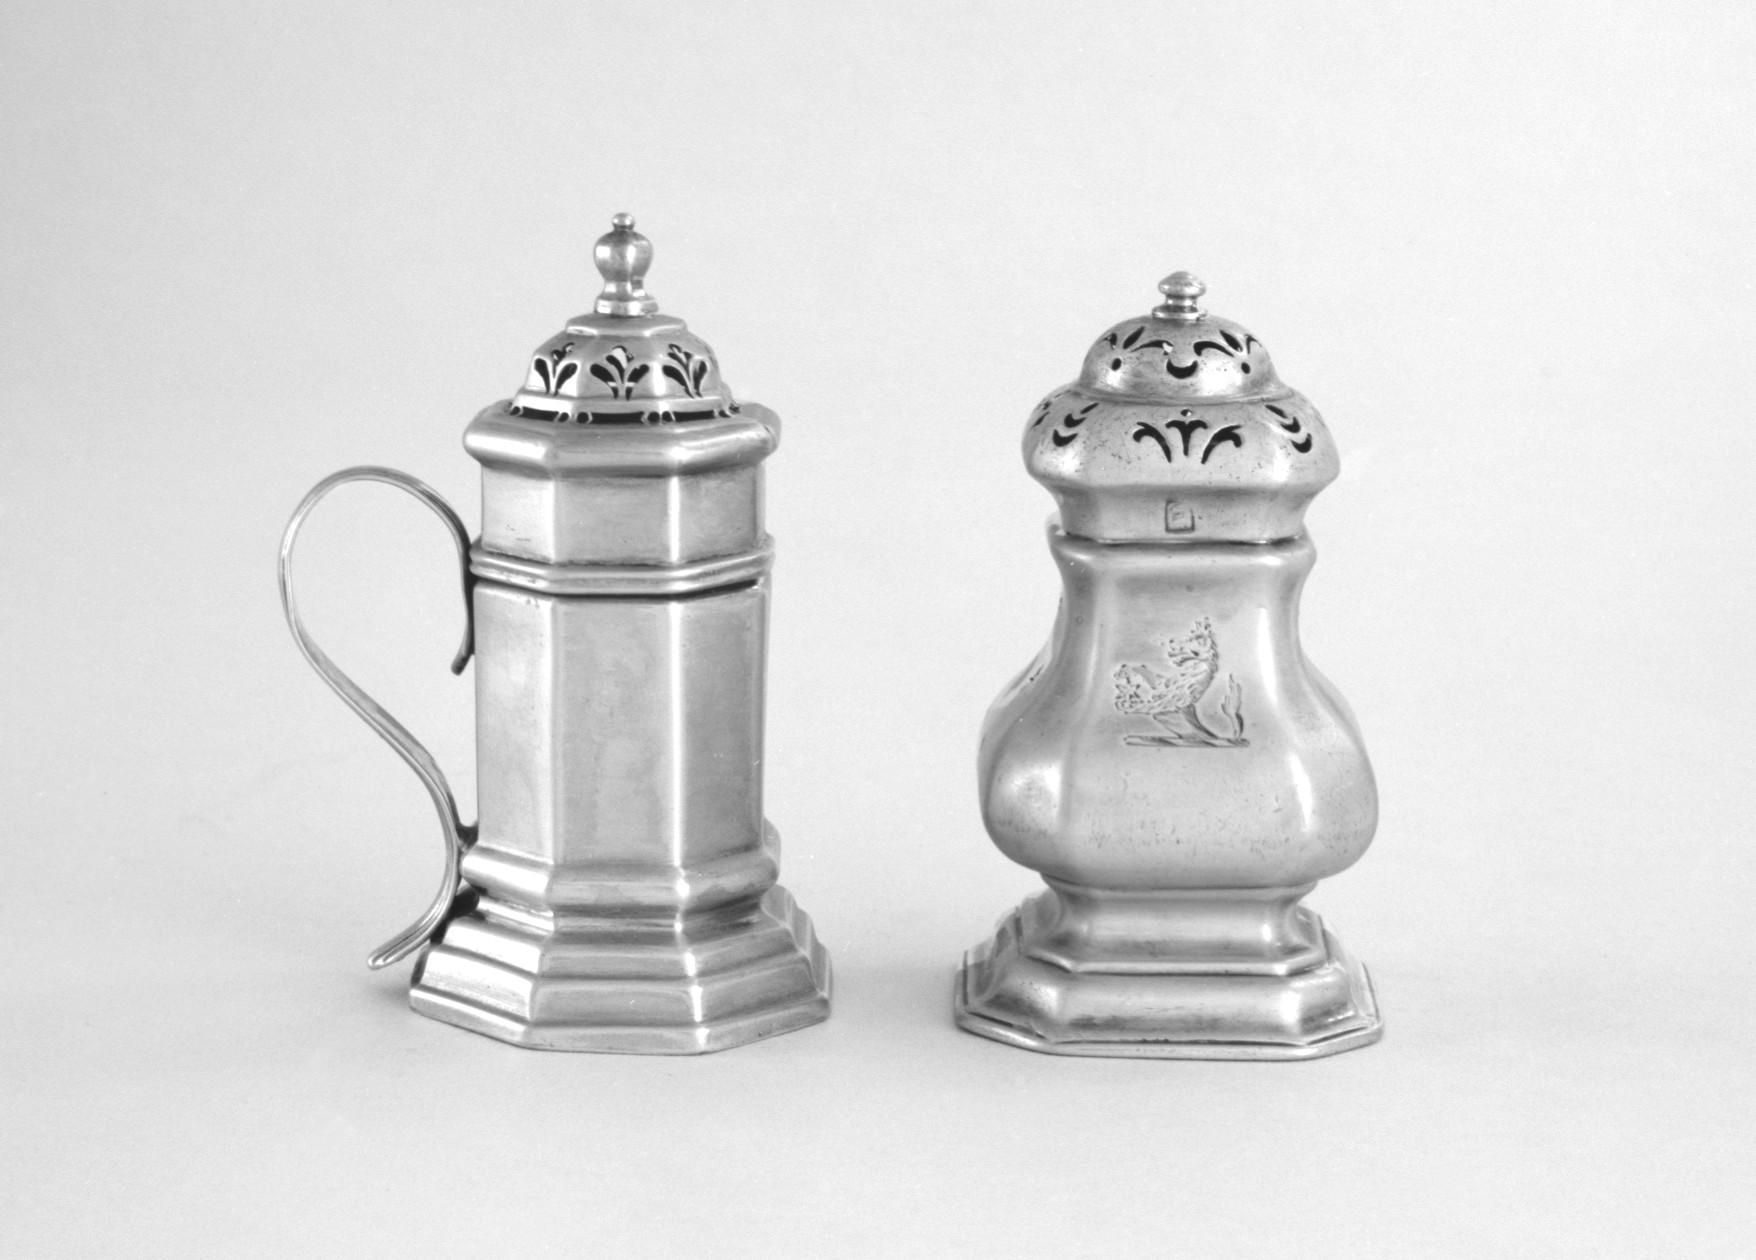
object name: dredger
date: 1725-1726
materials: silver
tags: animals